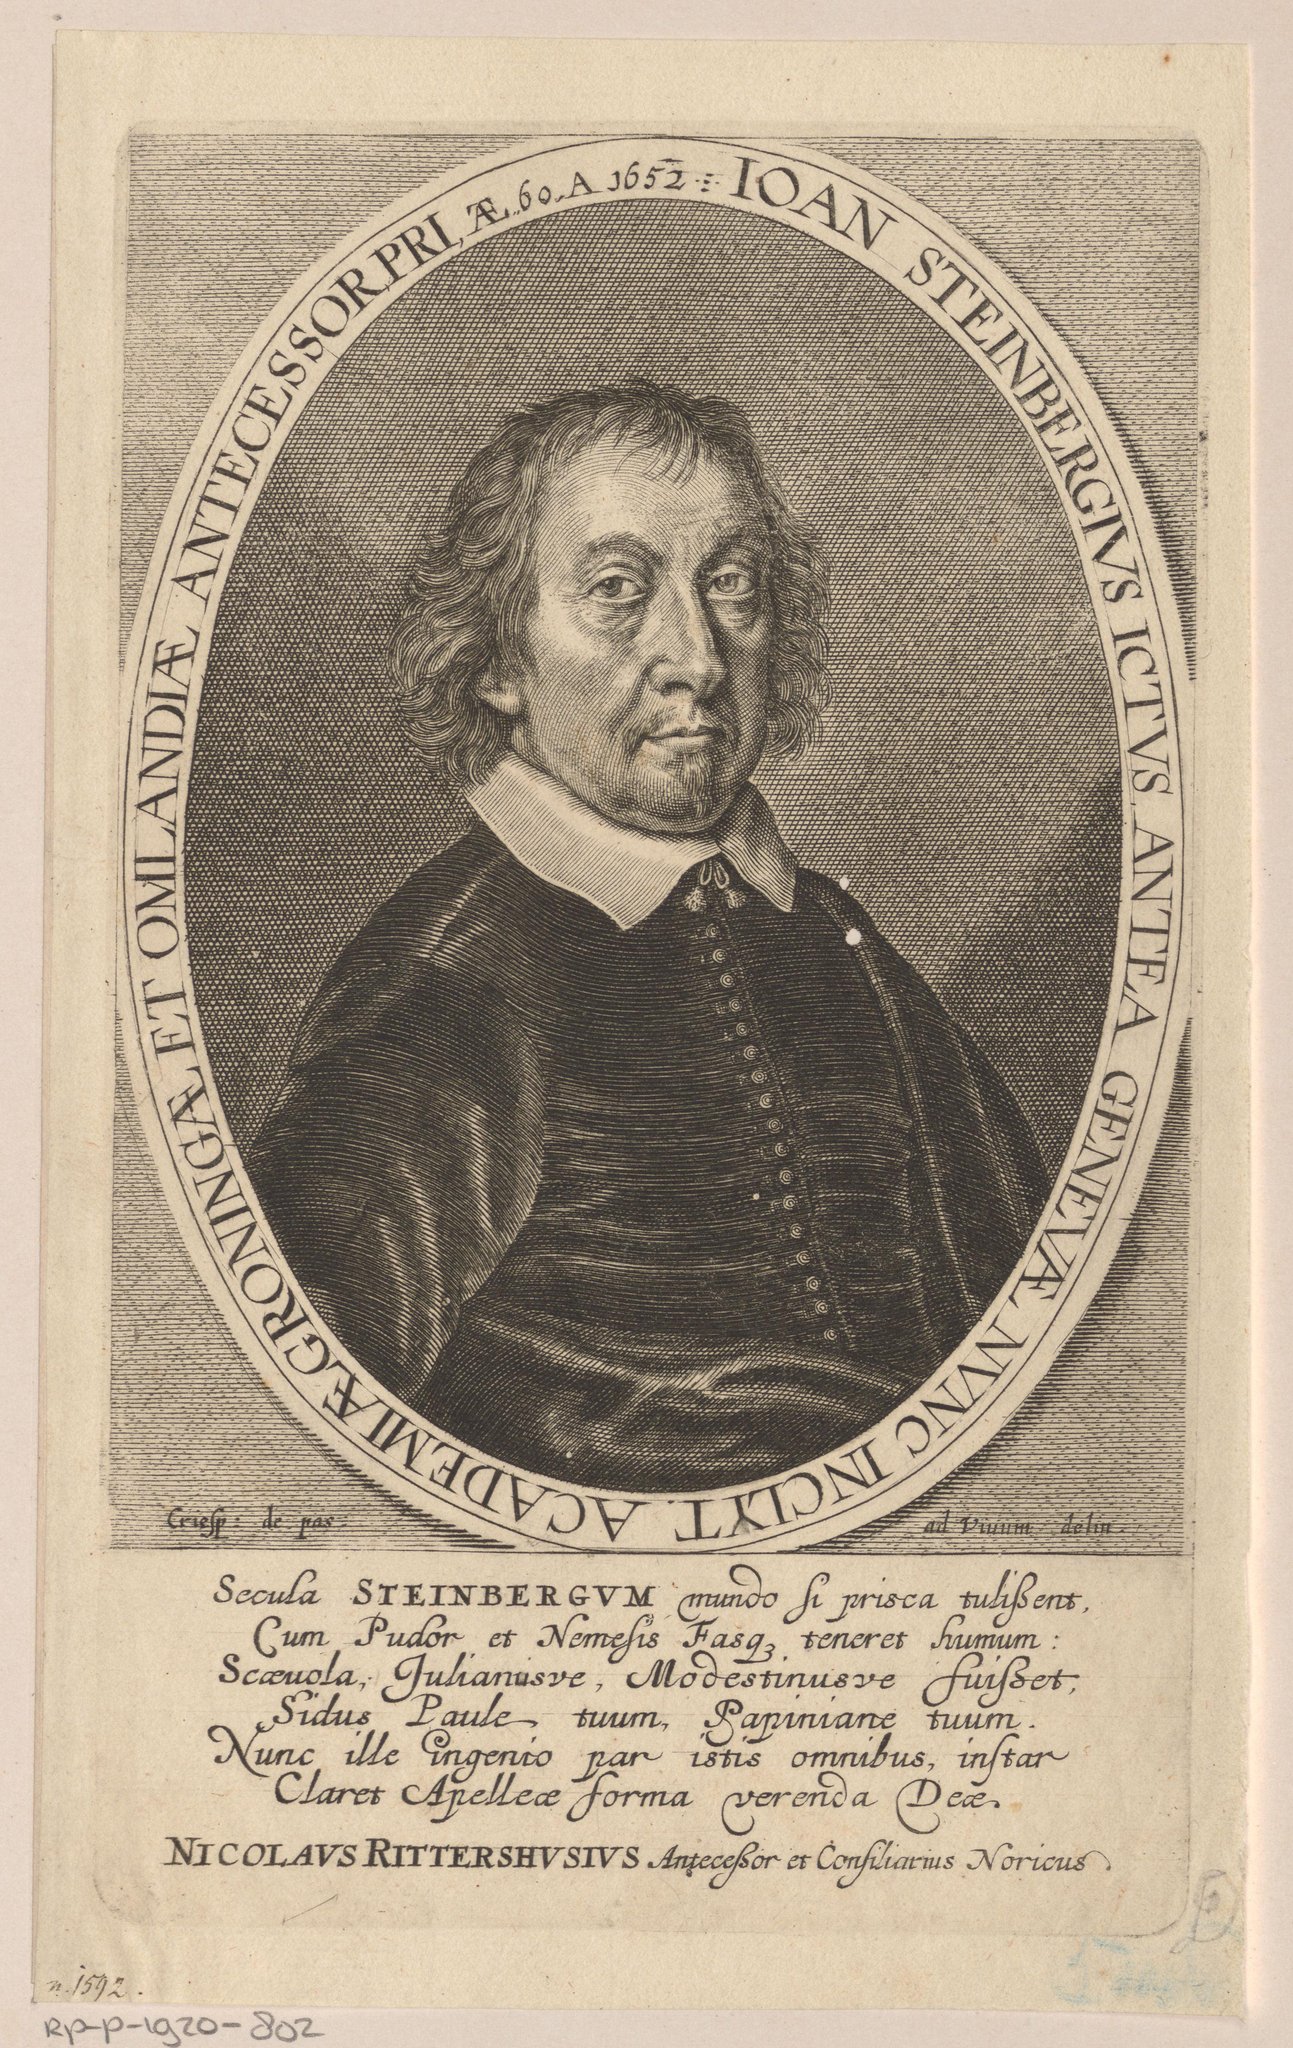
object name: print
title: Portret van Johannes Steinbergen op 60-jarige leeftijd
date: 1652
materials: paper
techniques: engraving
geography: amsterdam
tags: johannes steinbergen, historical persons, professor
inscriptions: collector's mark: Lugt 2228, inscription: ‘n. 1592.’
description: Prent ook gebruikt in: Nicolai, Johannes. Effigies & vitæ professorvm academiæ Groningæ & Omlandiæ. Groningen: Jan Claessen/Hindrick Lussinck, 1654.